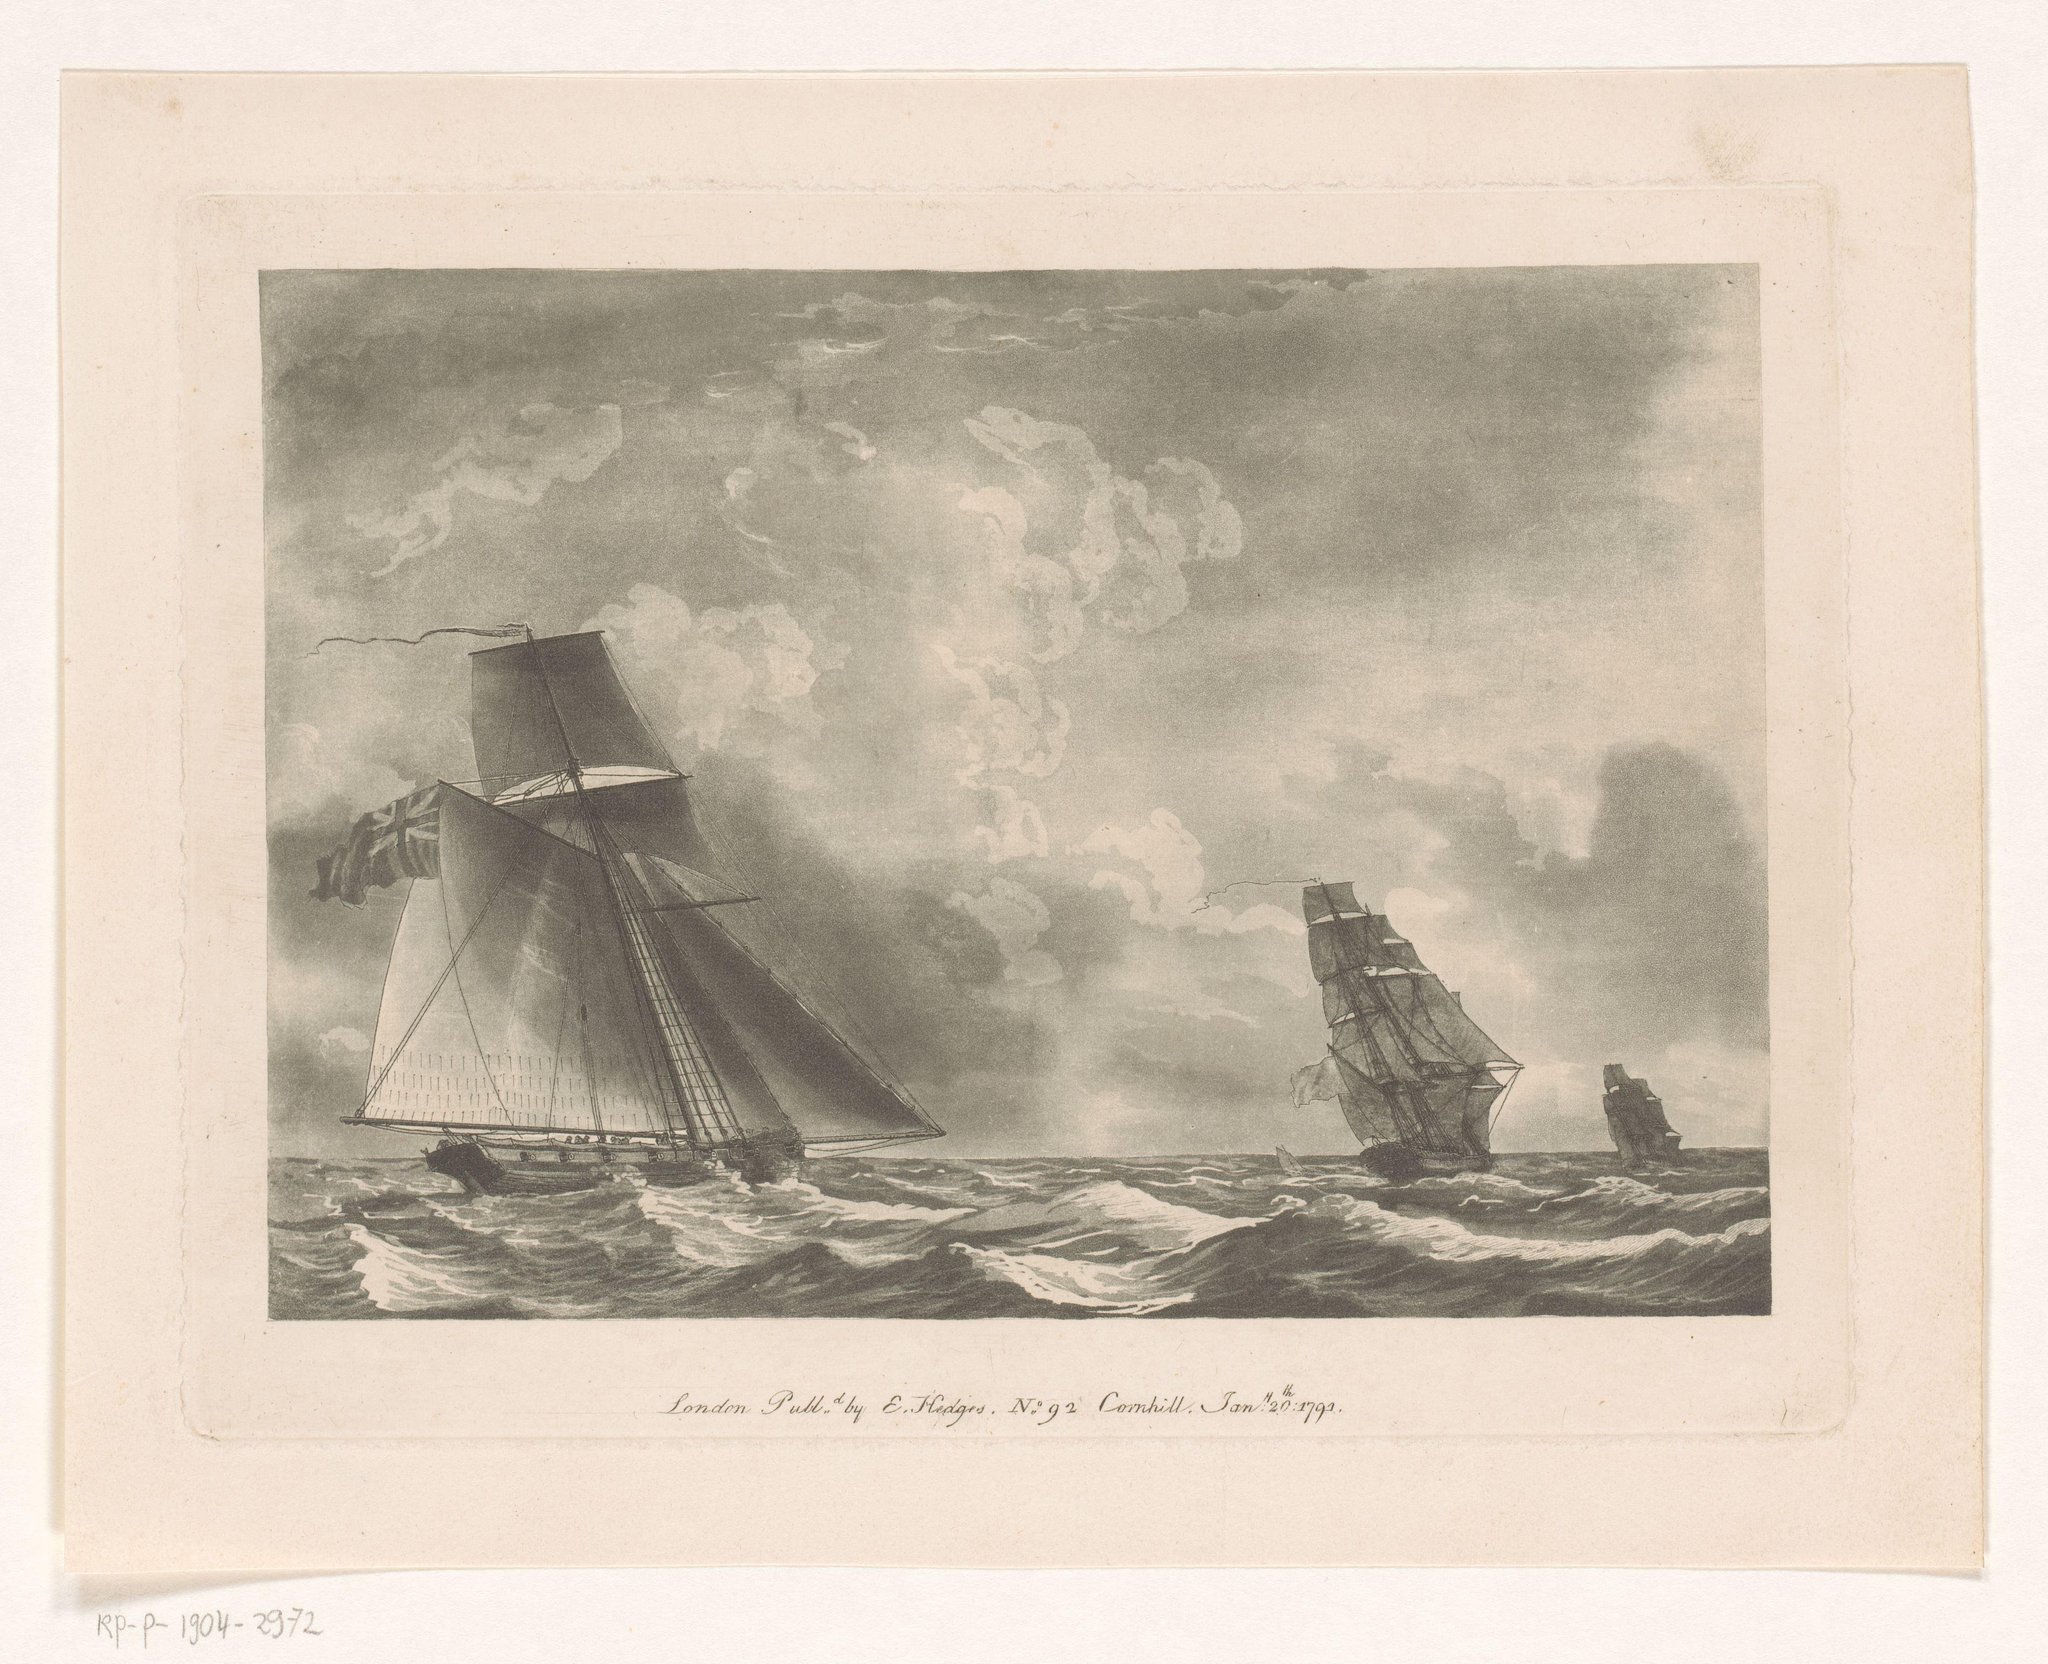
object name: print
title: Zeegezichten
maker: edward hedges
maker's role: publisher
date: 1791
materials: paper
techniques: mezzotint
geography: london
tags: ships (in general), sea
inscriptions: collector's mark: Lugt 2228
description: Deze prent maakt deel uit van een serie van vier prenten.